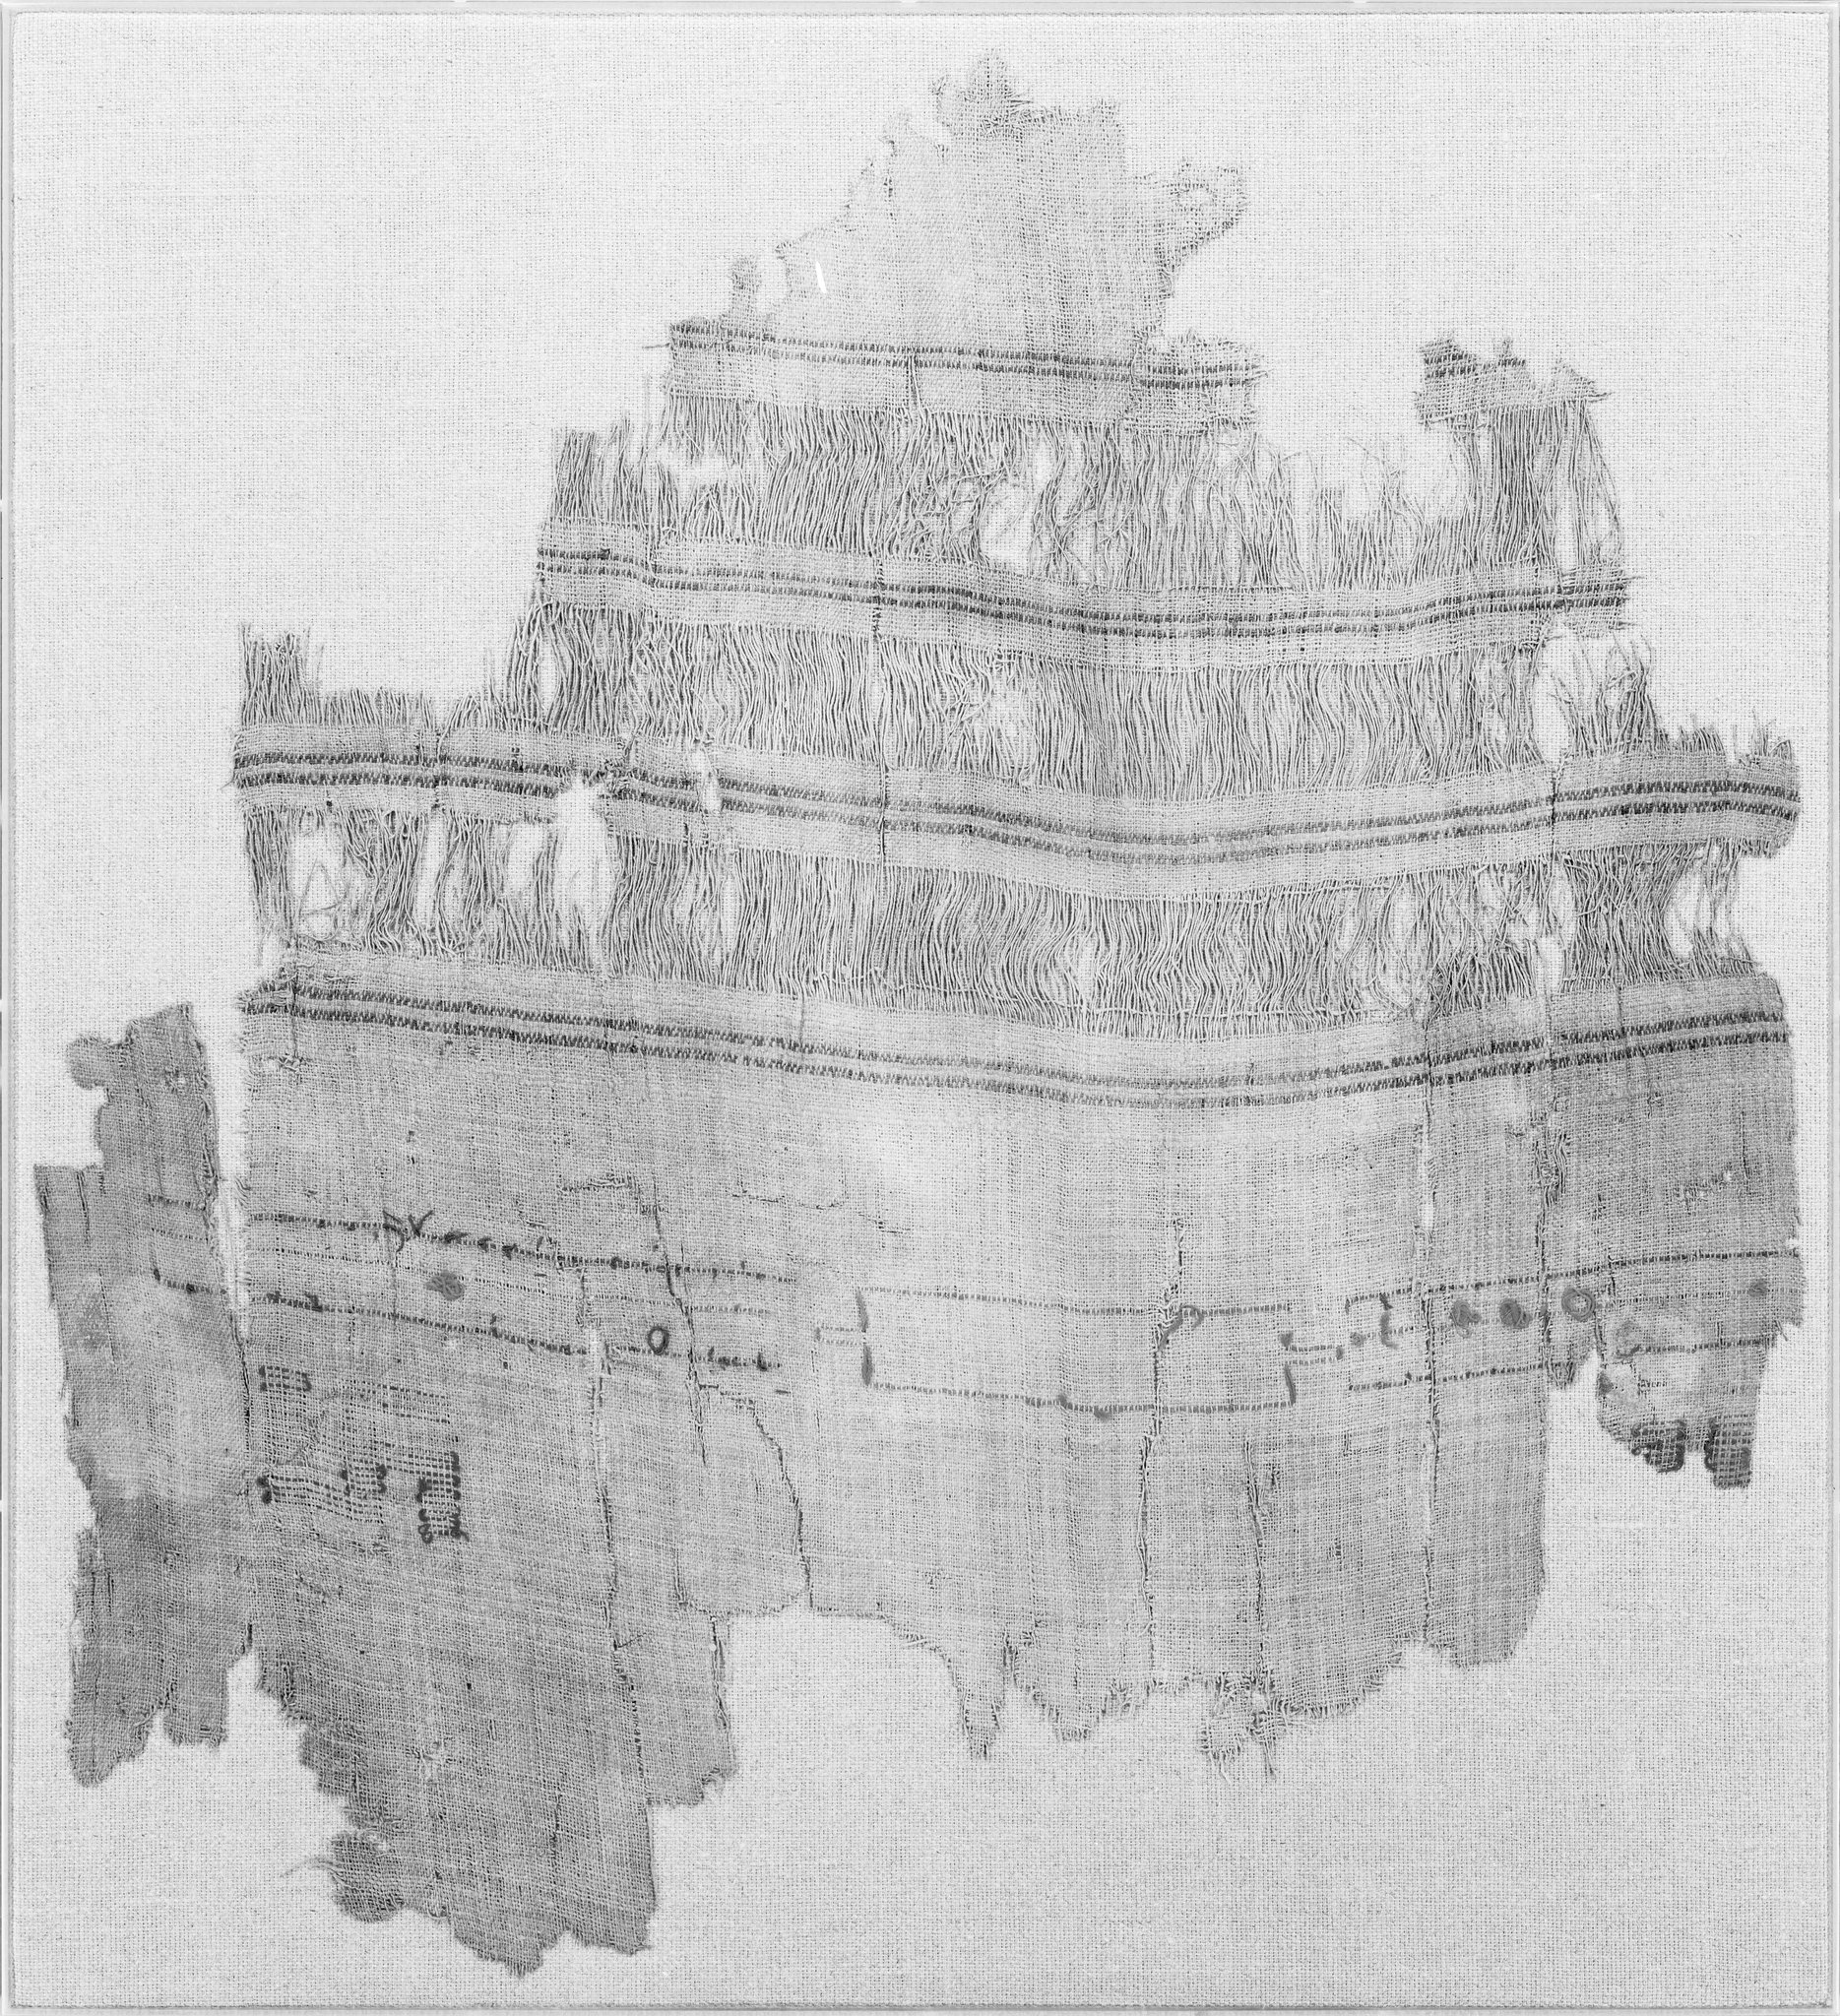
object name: fragment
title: Sheet Fragment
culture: coptic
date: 301-400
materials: linen, wool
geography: egypt